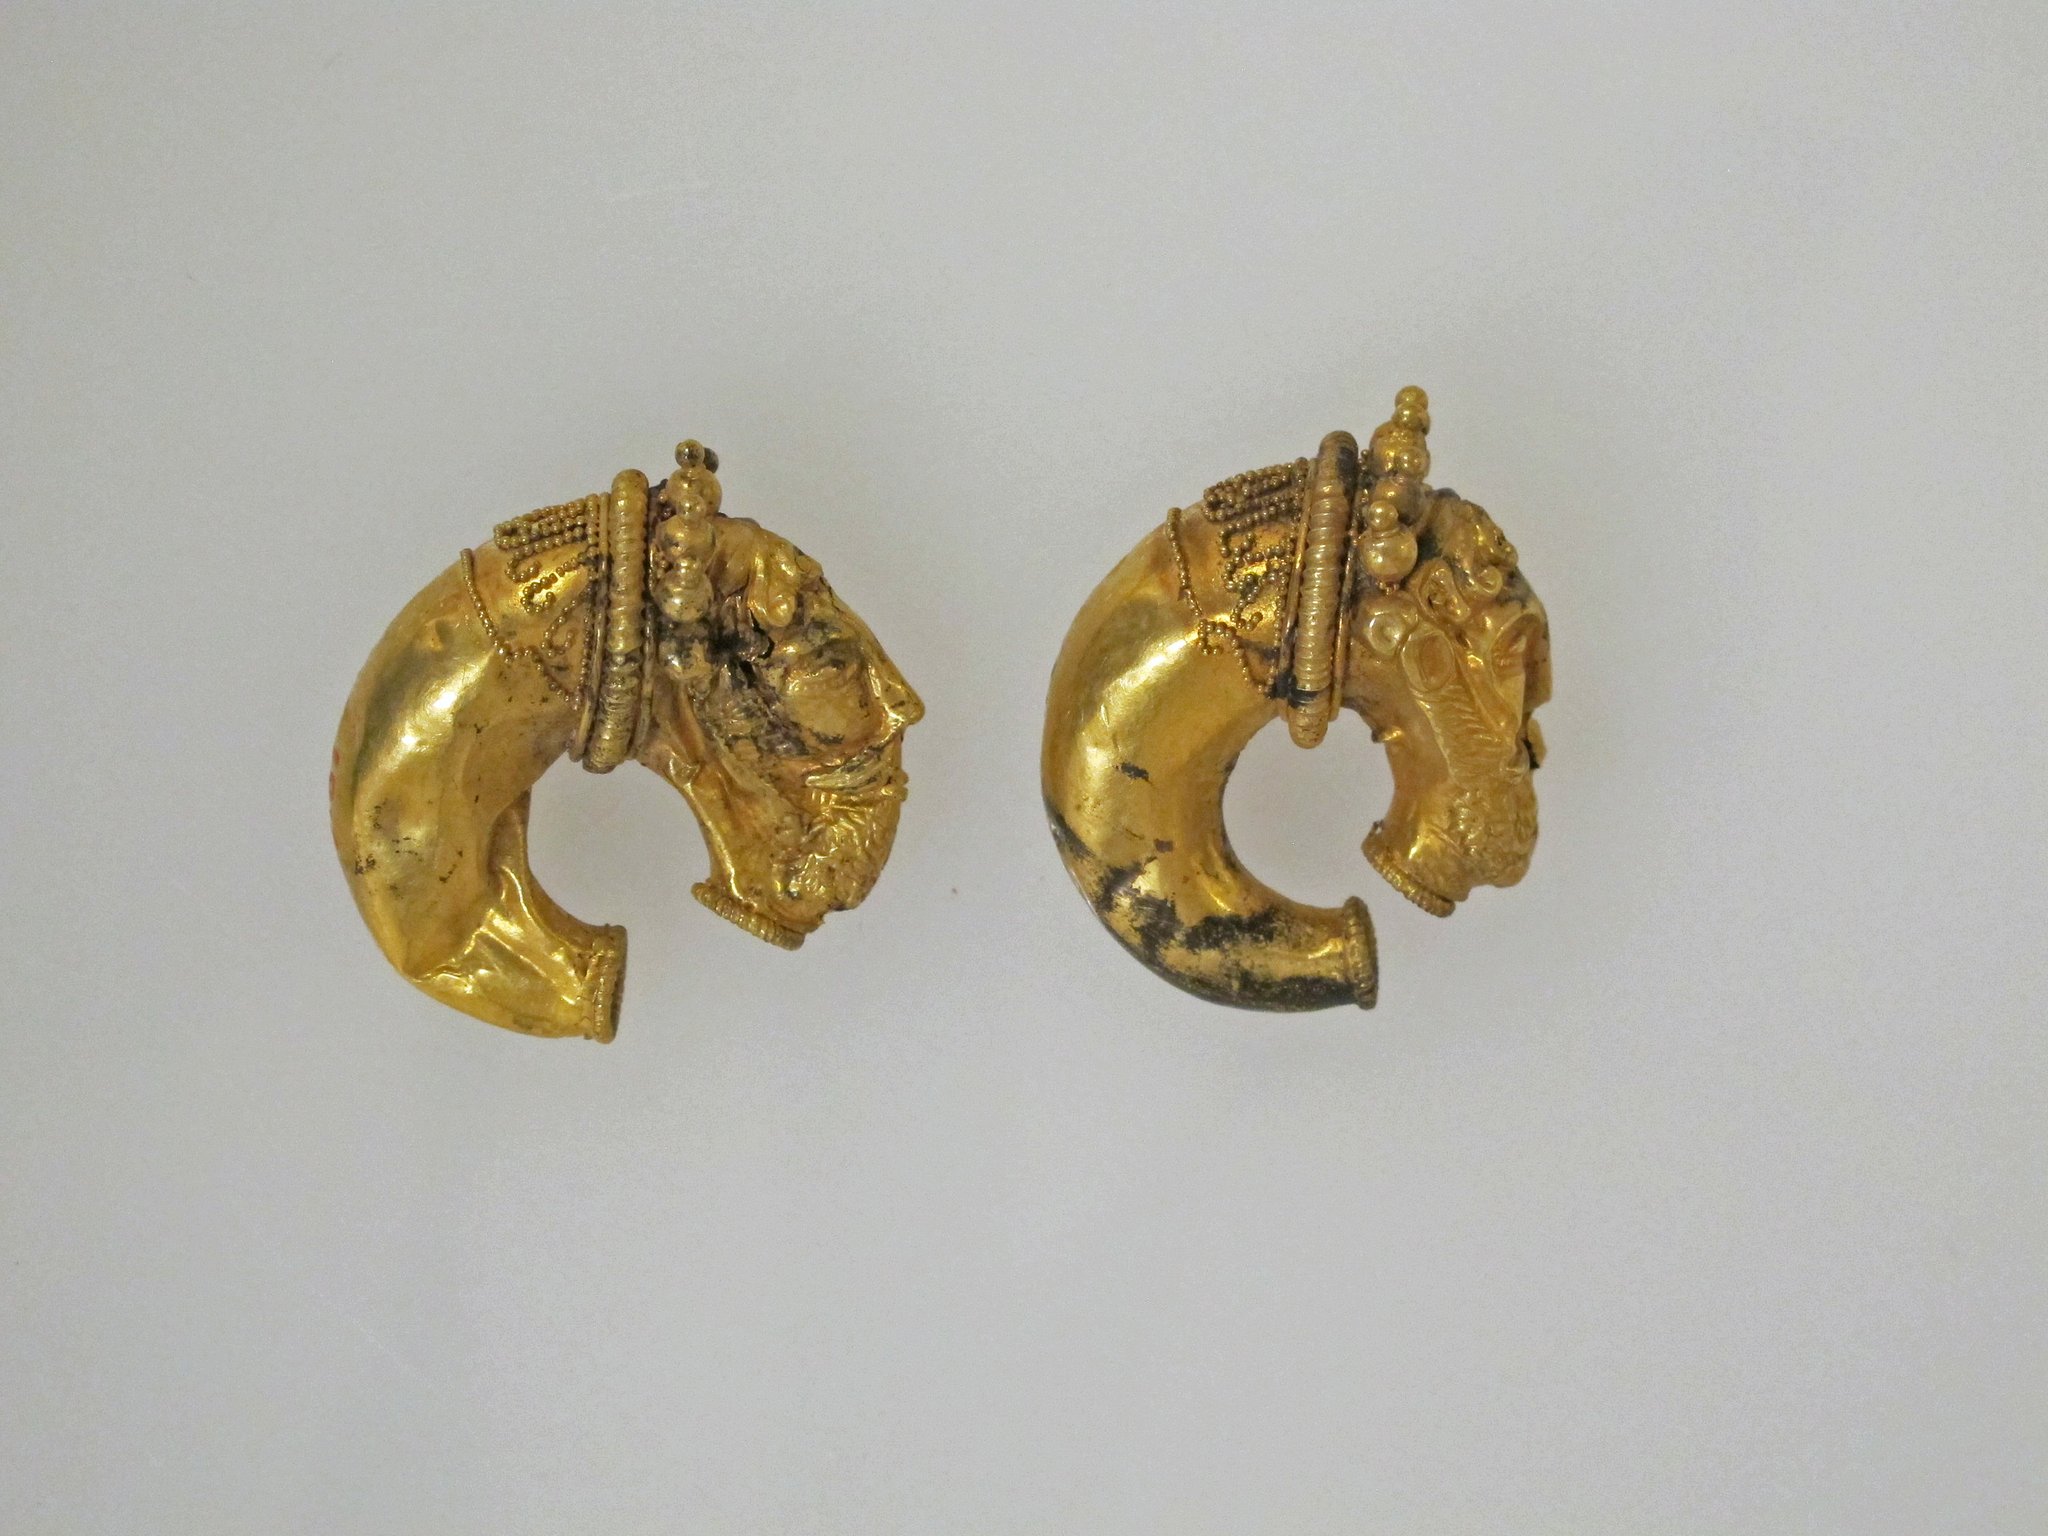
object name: earring with head of a man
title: Earrings with head of a man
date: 7000 BCE-330 CE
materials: gold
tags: heads,men